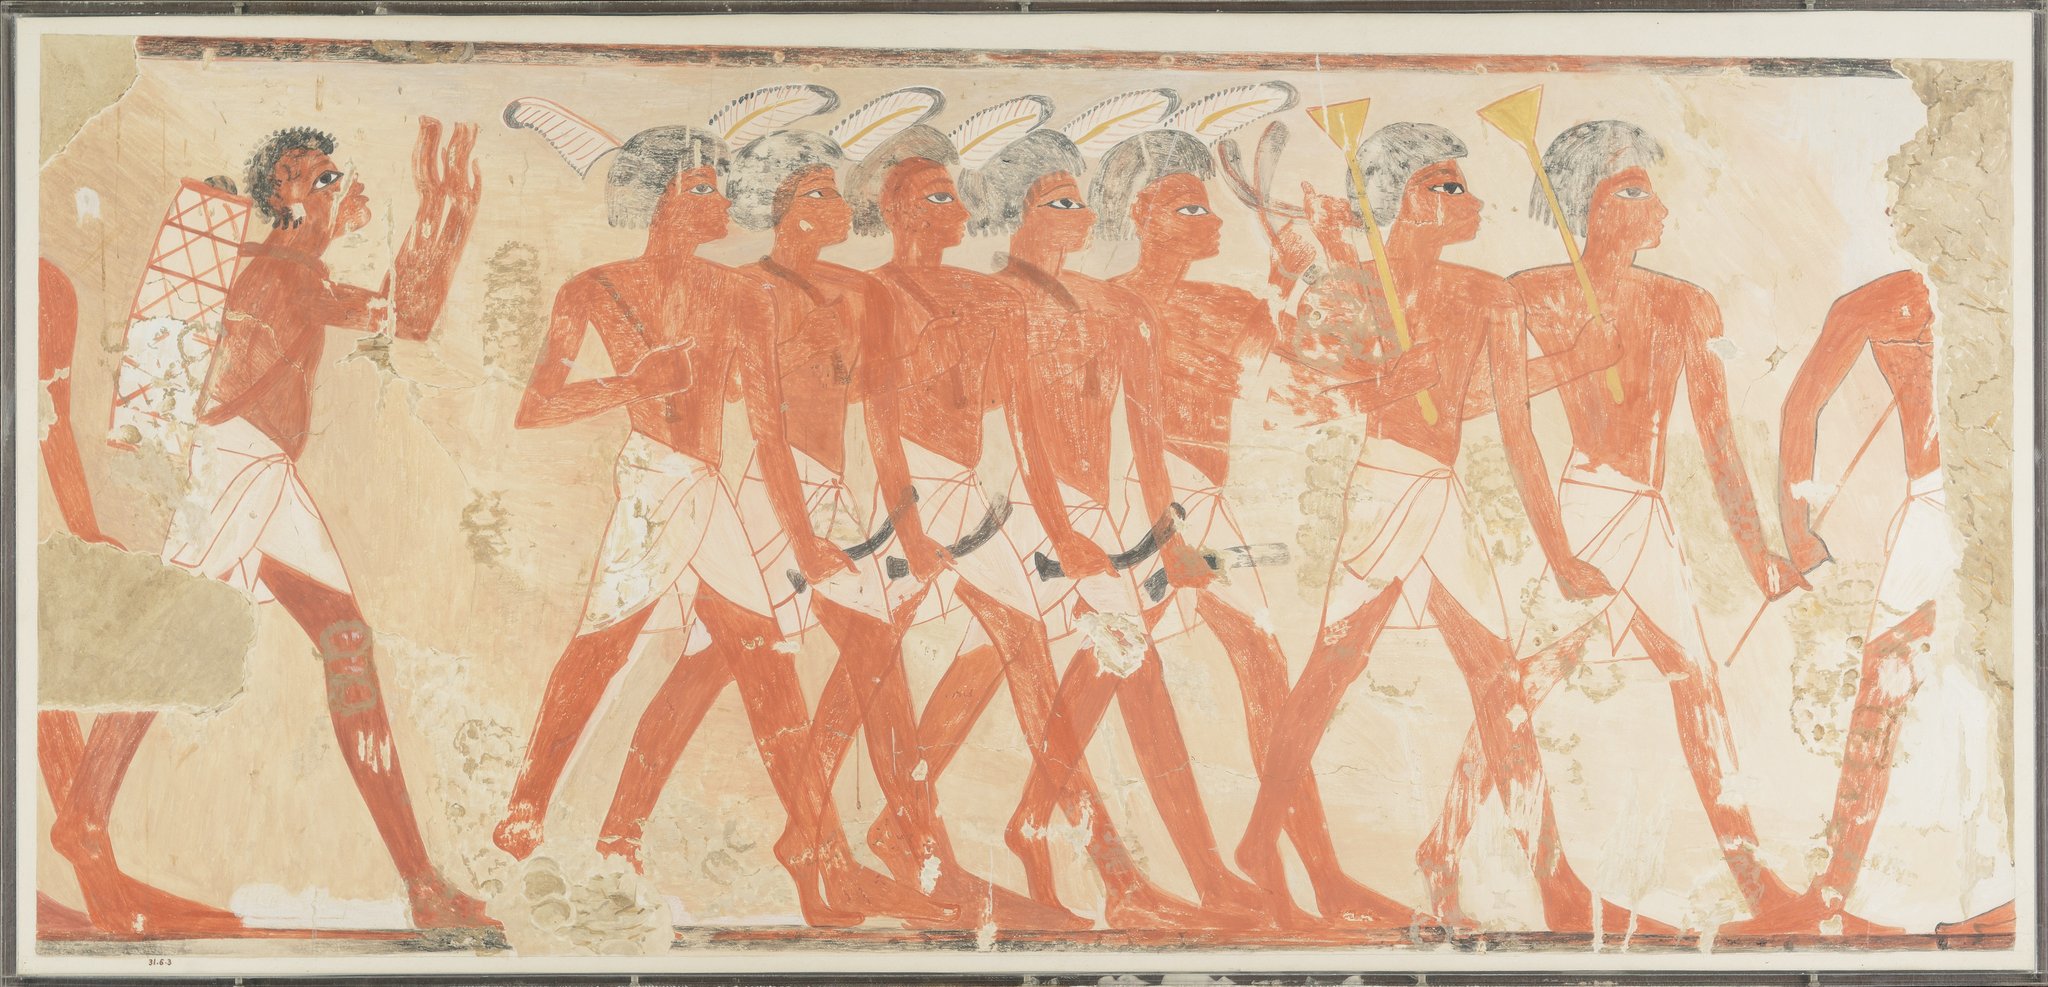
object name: facsimile, tjeneny tt 74, nubian soldier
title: Military Musicians Showing Nubian and Egyptian Styles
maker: nina de garis davies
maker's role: artist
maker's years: 1881-1965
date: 1400-1390 BCE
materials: paper, paint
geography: egypt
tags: soldiers,men,walk-like-egyptian